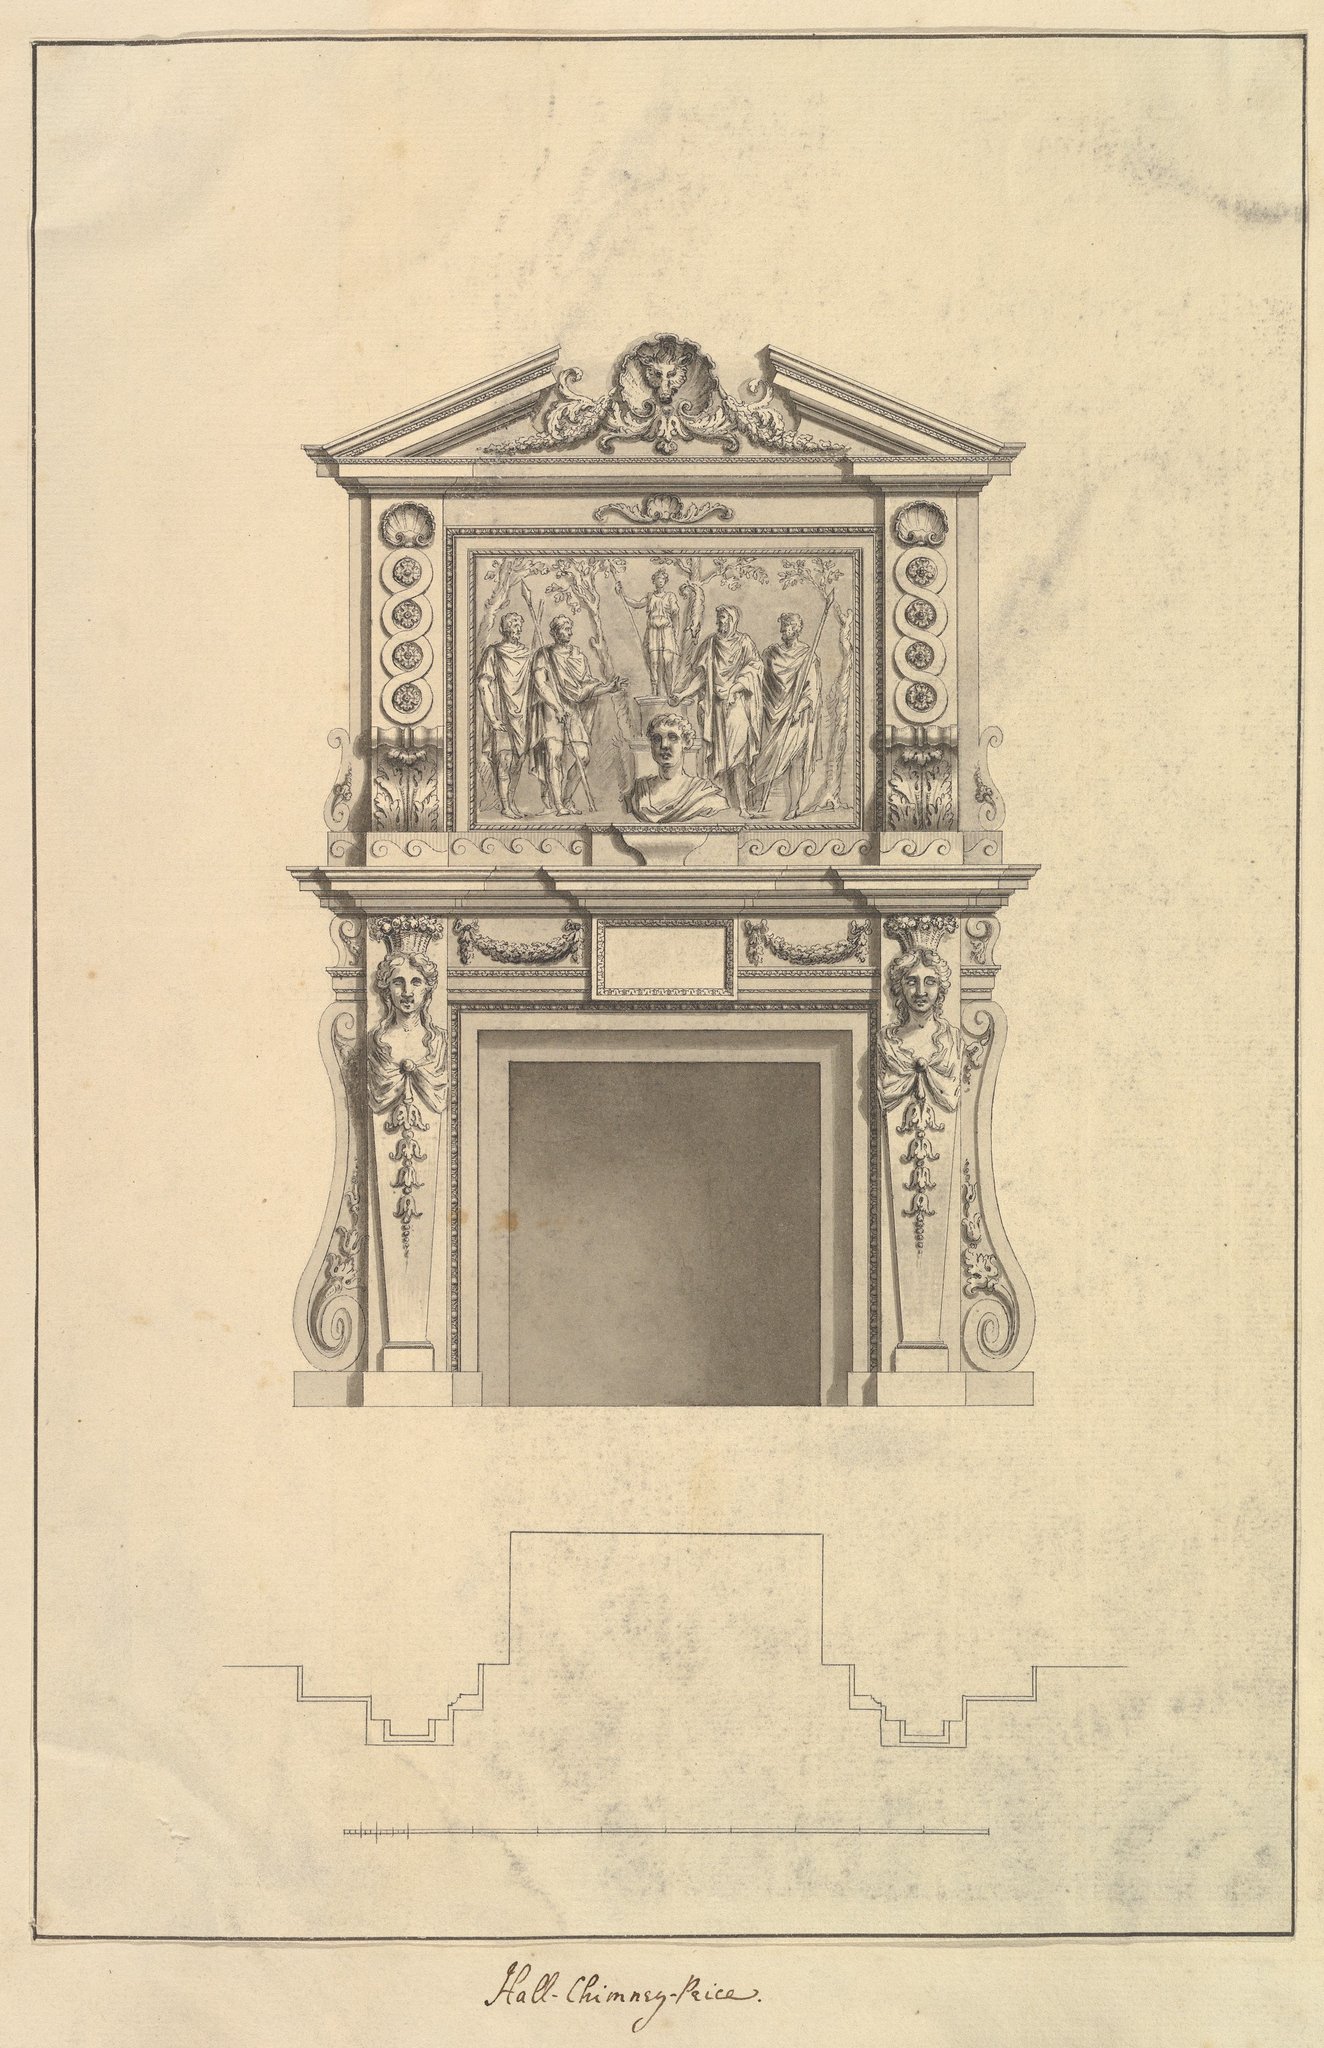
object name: drawing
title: Hall Chimney-Piece, Houghton Hall, Norfolk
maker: isaac ware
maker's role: artist and architect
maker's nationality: british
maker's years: 1704-1766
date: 1735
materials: ink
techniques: brush, pen, wash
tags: architecture